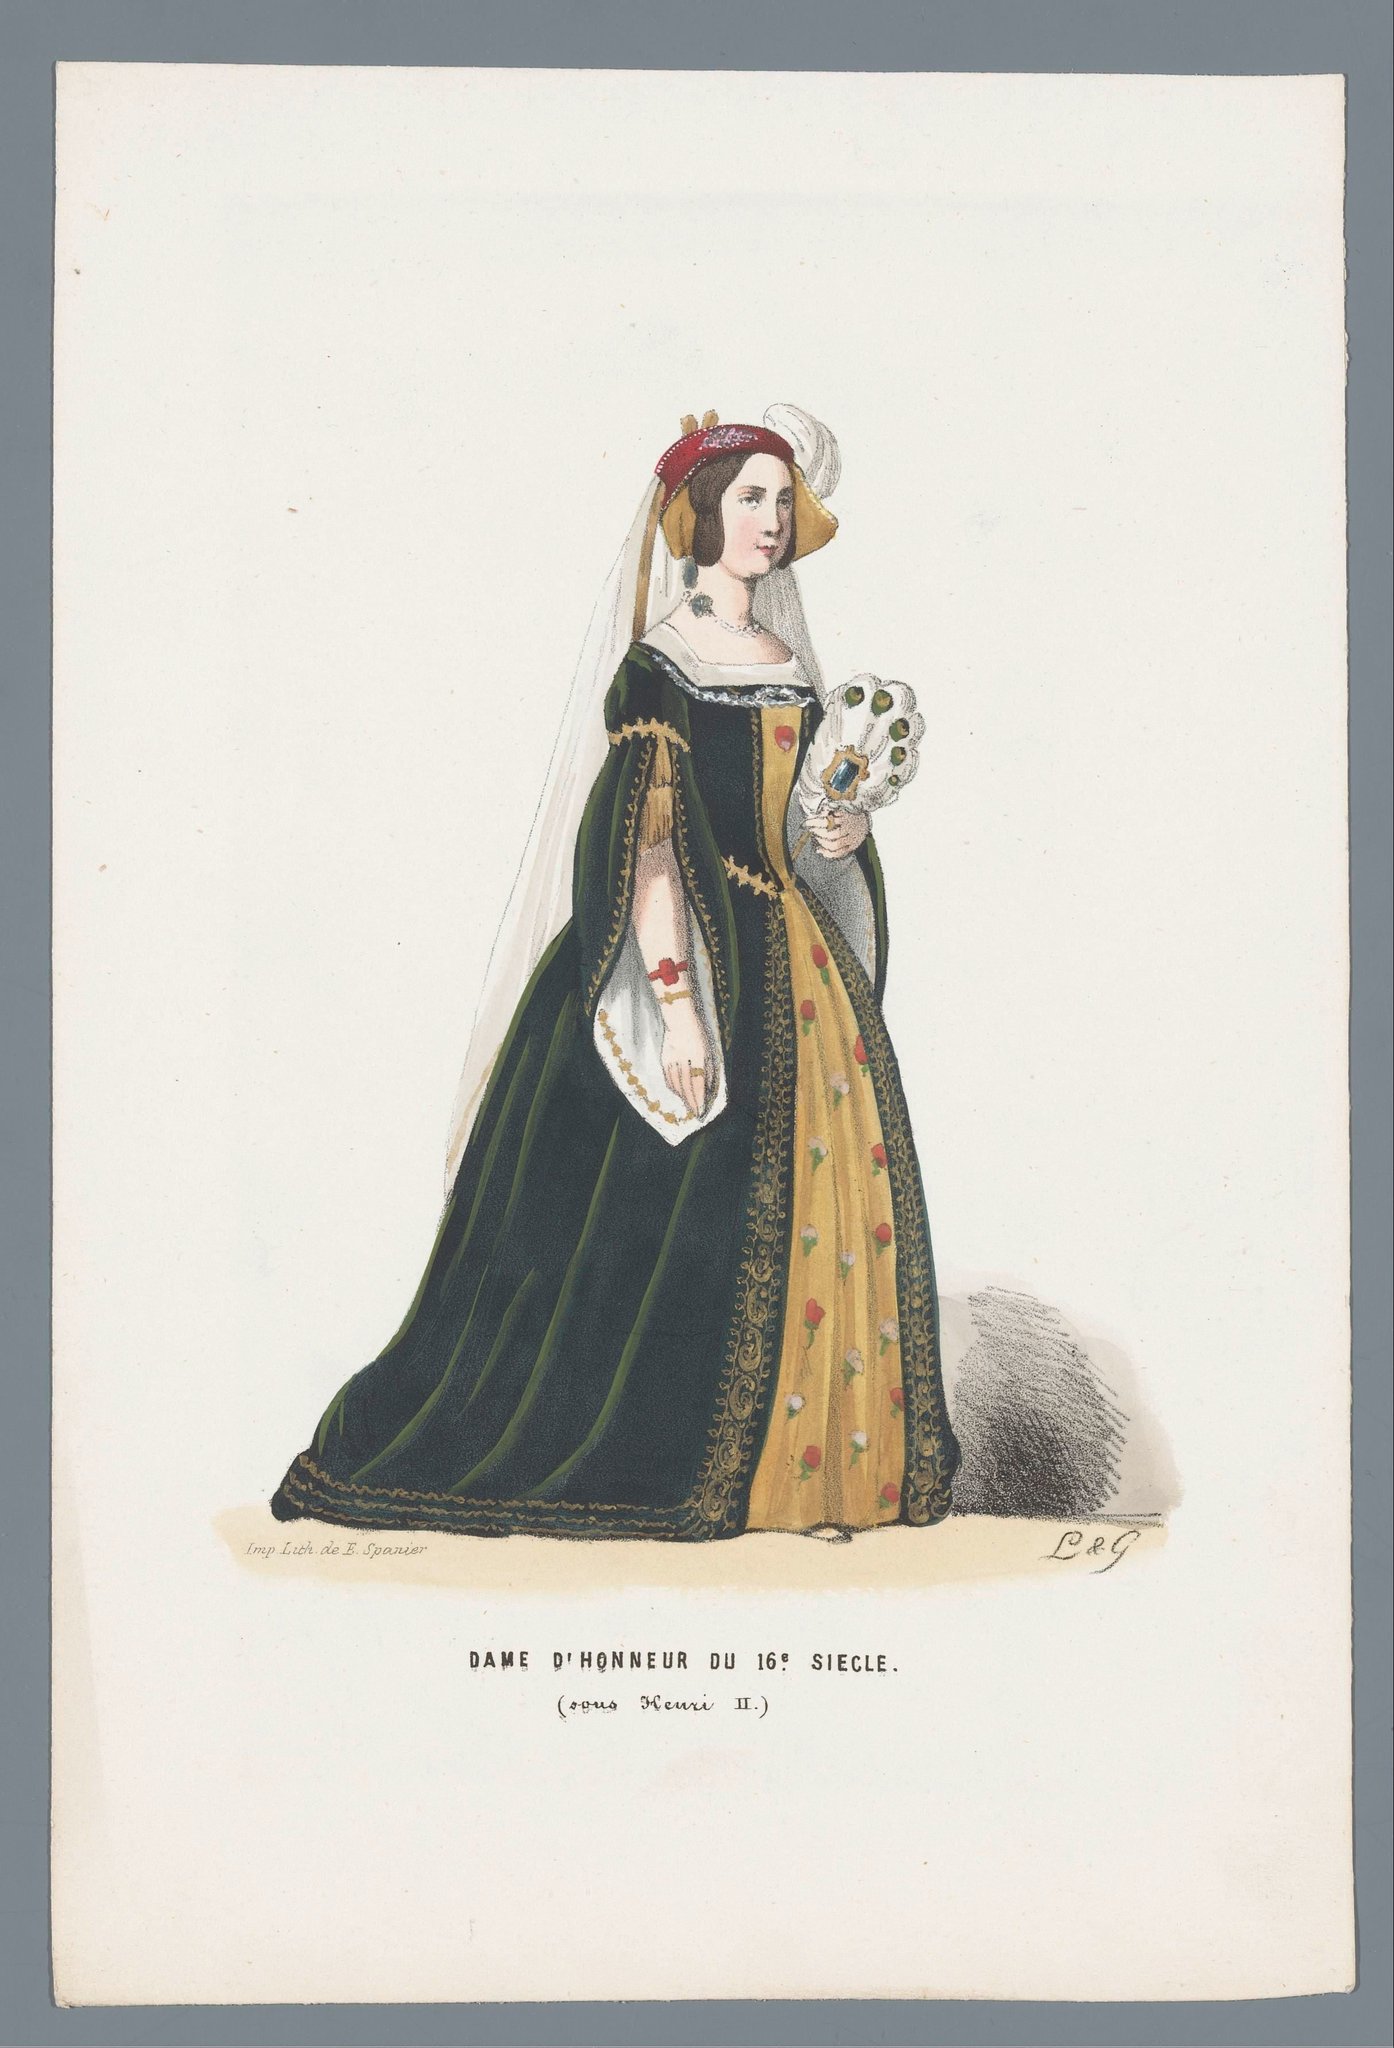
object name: costume print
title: Dame D'Honneur du 16de Siècle (sous Henri II)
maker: elias spanier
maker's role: print maker, printer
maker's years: 1821-1863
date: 1840-1850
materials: paper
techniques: hand coloring, lithograph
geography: netherlands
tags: historical costume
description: Vrouw in historisch kostuum van een hofdame aan het hof van Hendrik II, 16e eeuw. Voorstelling toegevoegd aan het plaatwerk over het gekostumeerd bal gehouden op het paleis van de prins van Oranje (de latere koning Willem III) in Den Haag op 26 februari 1845.